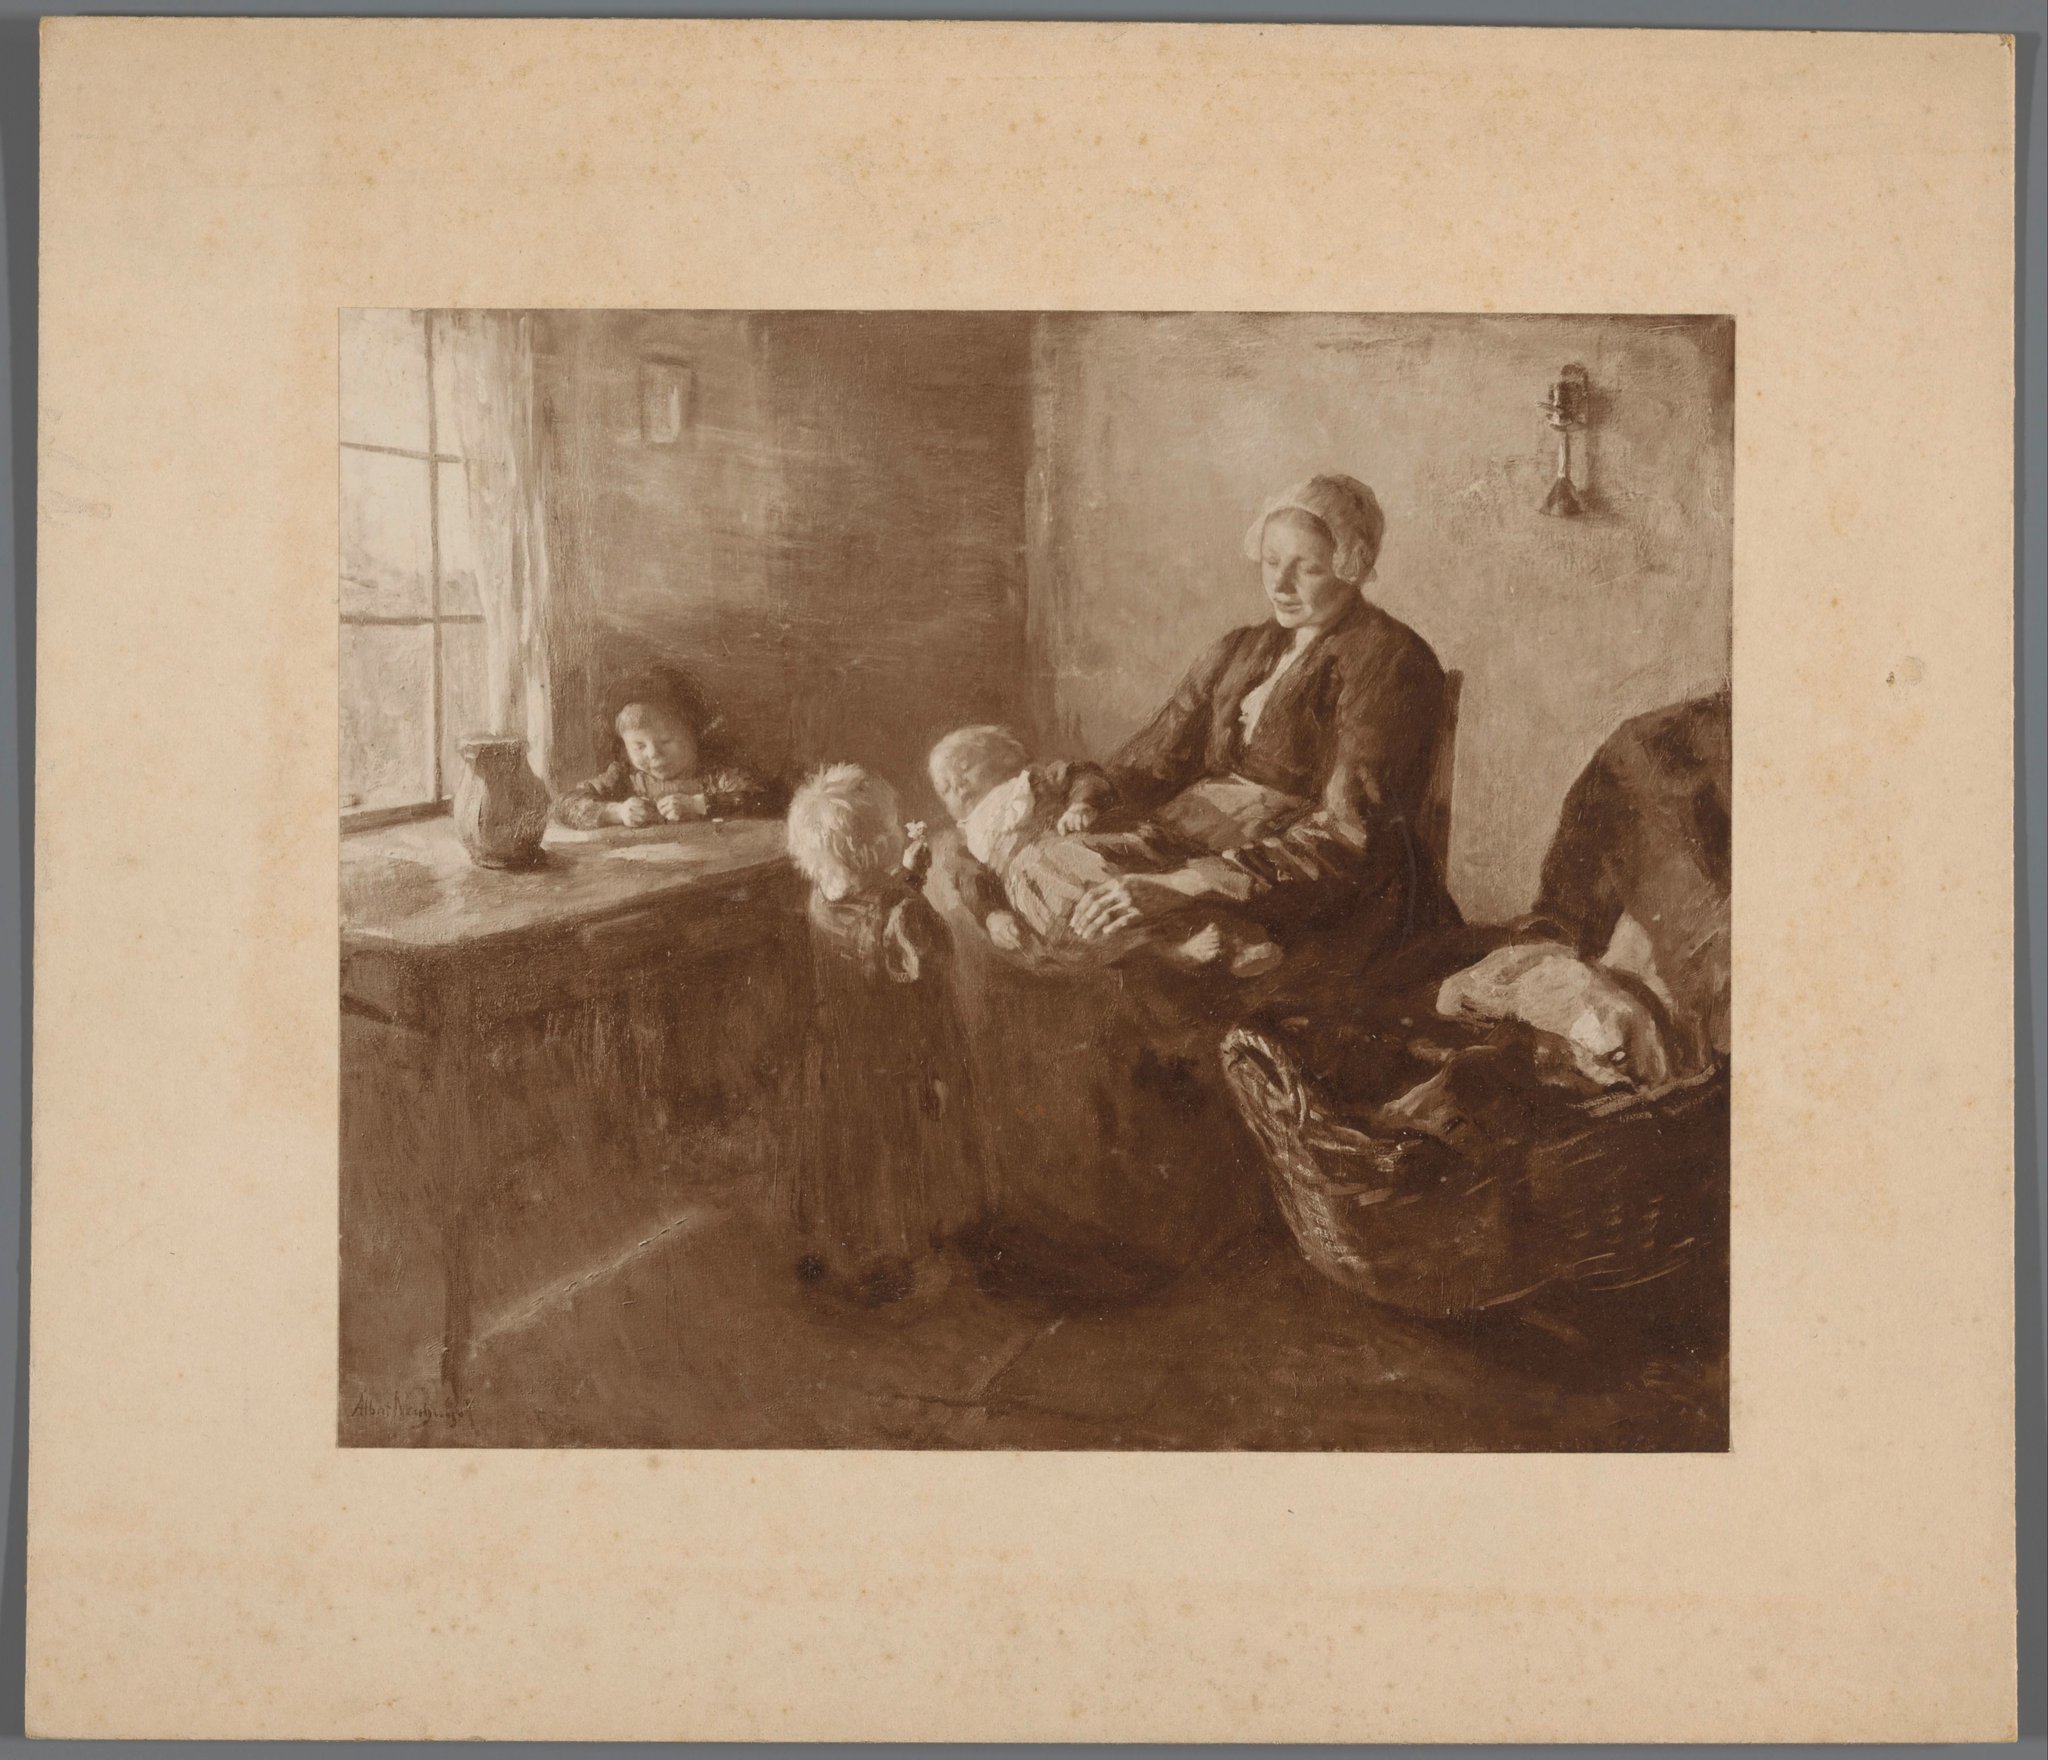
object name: photograph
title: Fotoreproductie van schilderij door Albert Neuhuys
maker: Anonymous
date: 1850-1900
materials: cardboard, photographic support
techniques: albumen print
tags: adult woman, child, cradle, crib